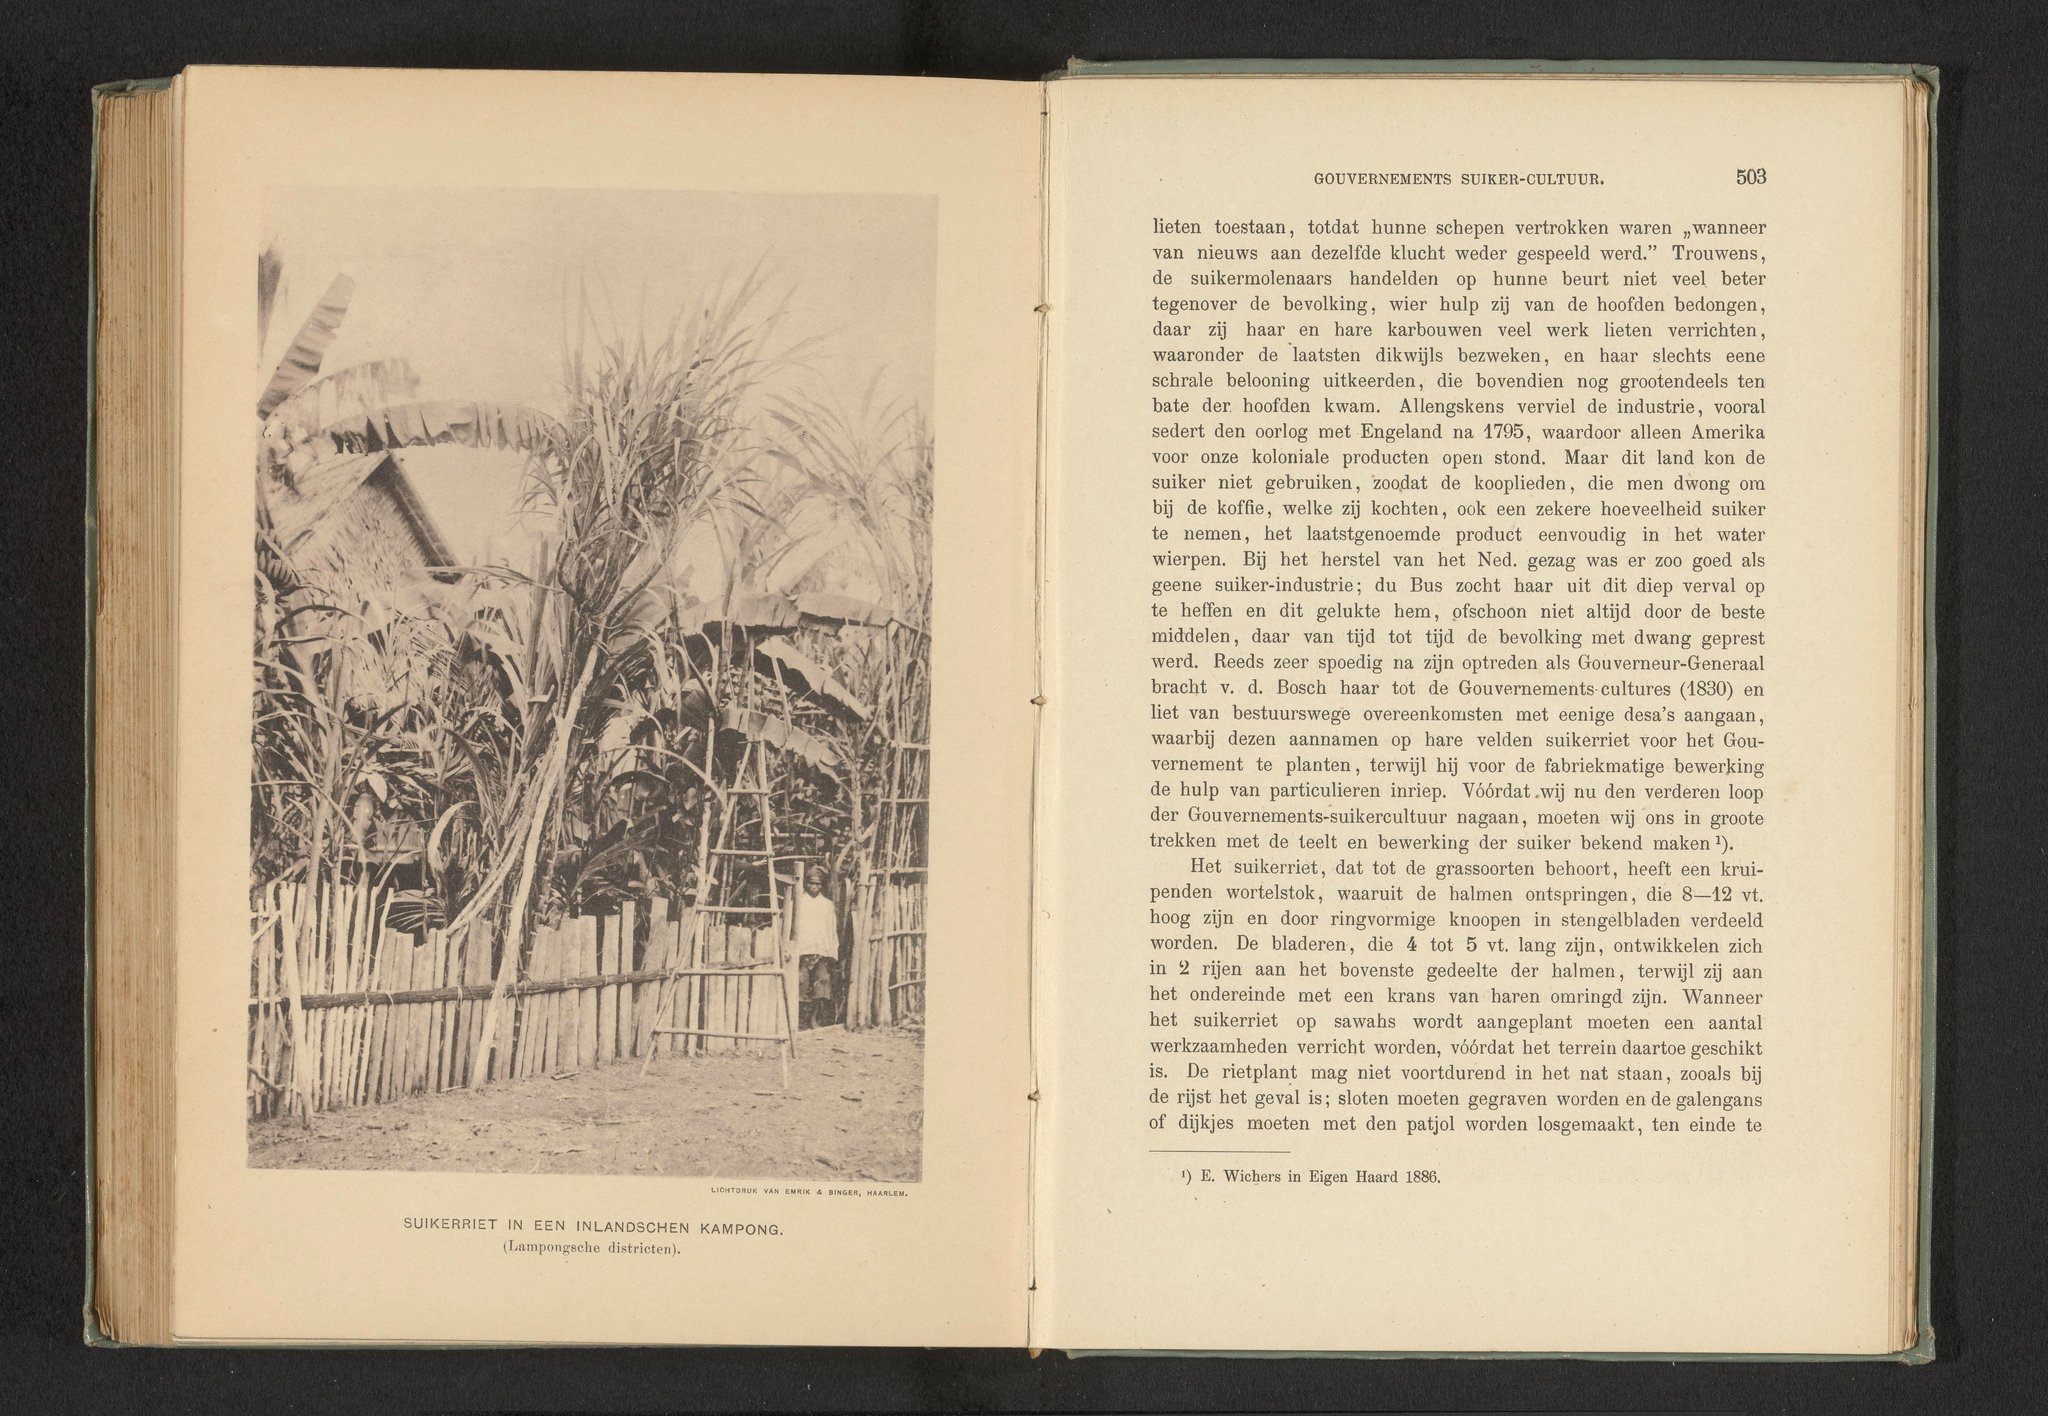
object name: photomechanical print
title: Suikerriet in een inlandschen kampong. (Lampongsche districhten)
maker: Anonymous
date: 1883-1894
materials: paper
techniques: photograph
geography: dutch east indies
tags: plants and herbs: sugarcane